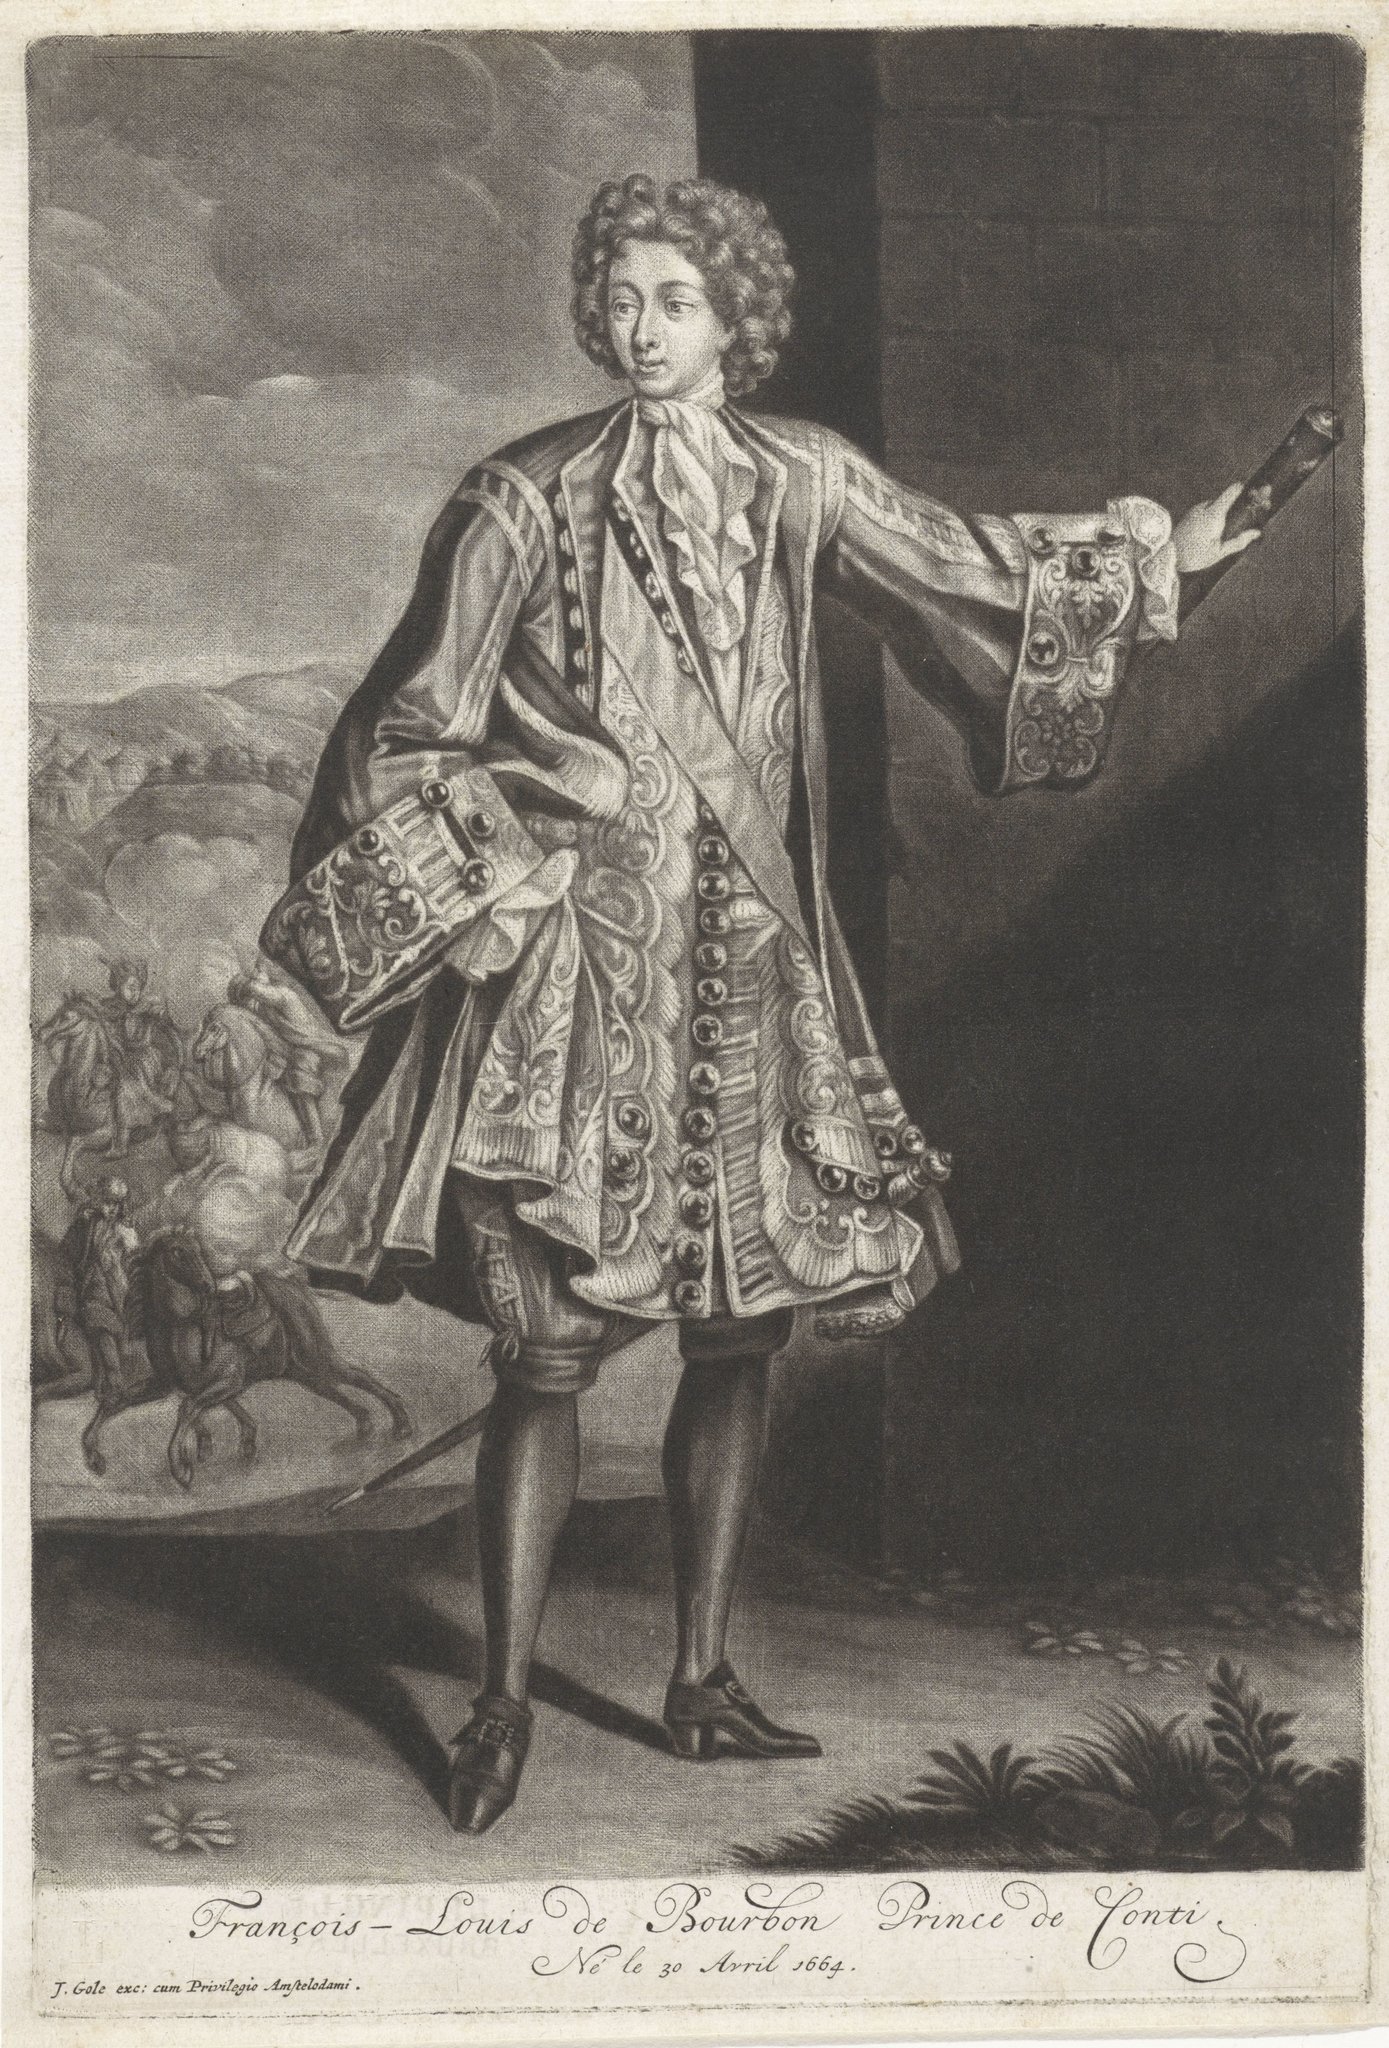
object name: print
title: Portret van François Louis de Bourbon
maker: jacob gole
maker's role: print maker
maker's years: 1660-1724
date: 1679-1724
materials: paper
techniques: engraving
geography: amsterdam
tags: françois louis de bourbon (prins van condé)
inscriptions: collector's mark: Lugt 2228, collector's mark: Lugt 1731, collector's mark: Lugt 1672b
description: Portret van François Louis de Bourbon, prins van Condé. Op de achtergrond een ruitergevecht.